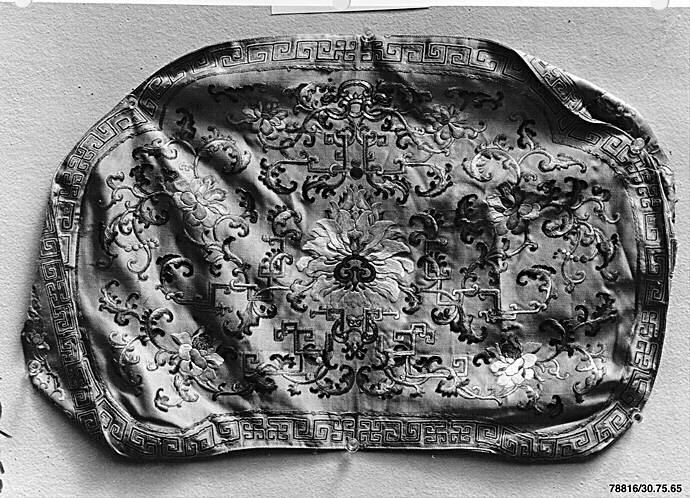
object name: cushion cover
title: One of a Pair of Cushion Covers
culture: chinese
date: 1736-1795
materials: metal thread, silk